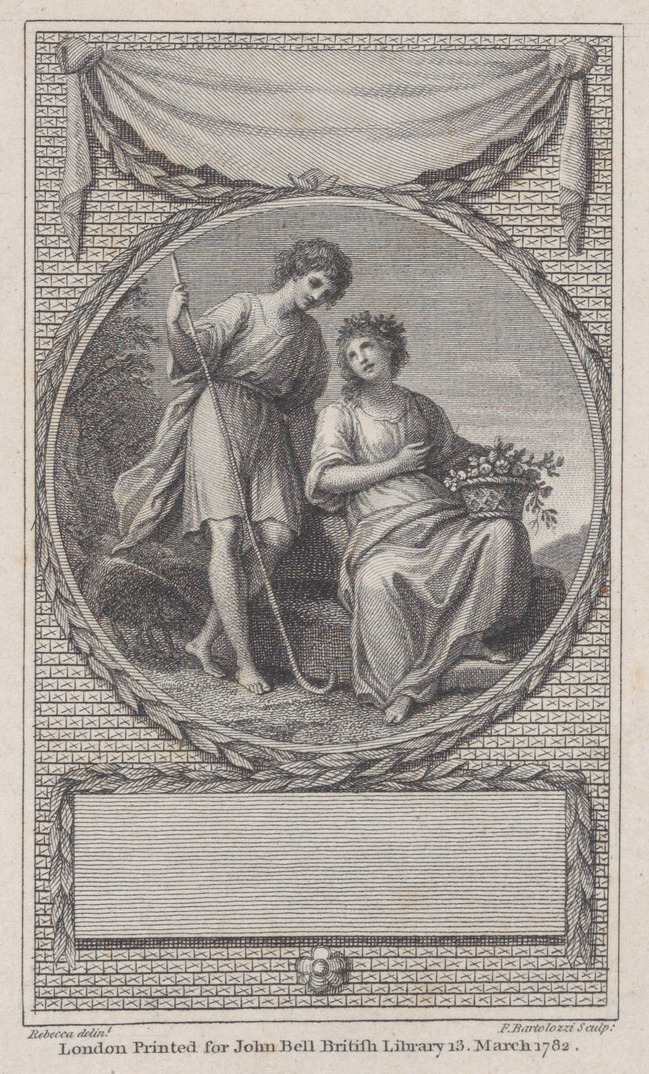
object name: print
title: Idyll: Frontispiece to "The Poets of Great Britain, Complete from Chaucer to Churchill"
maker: francesco bartolozzi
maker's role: artist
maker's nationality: italian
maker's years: 1728-1815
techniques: engraving